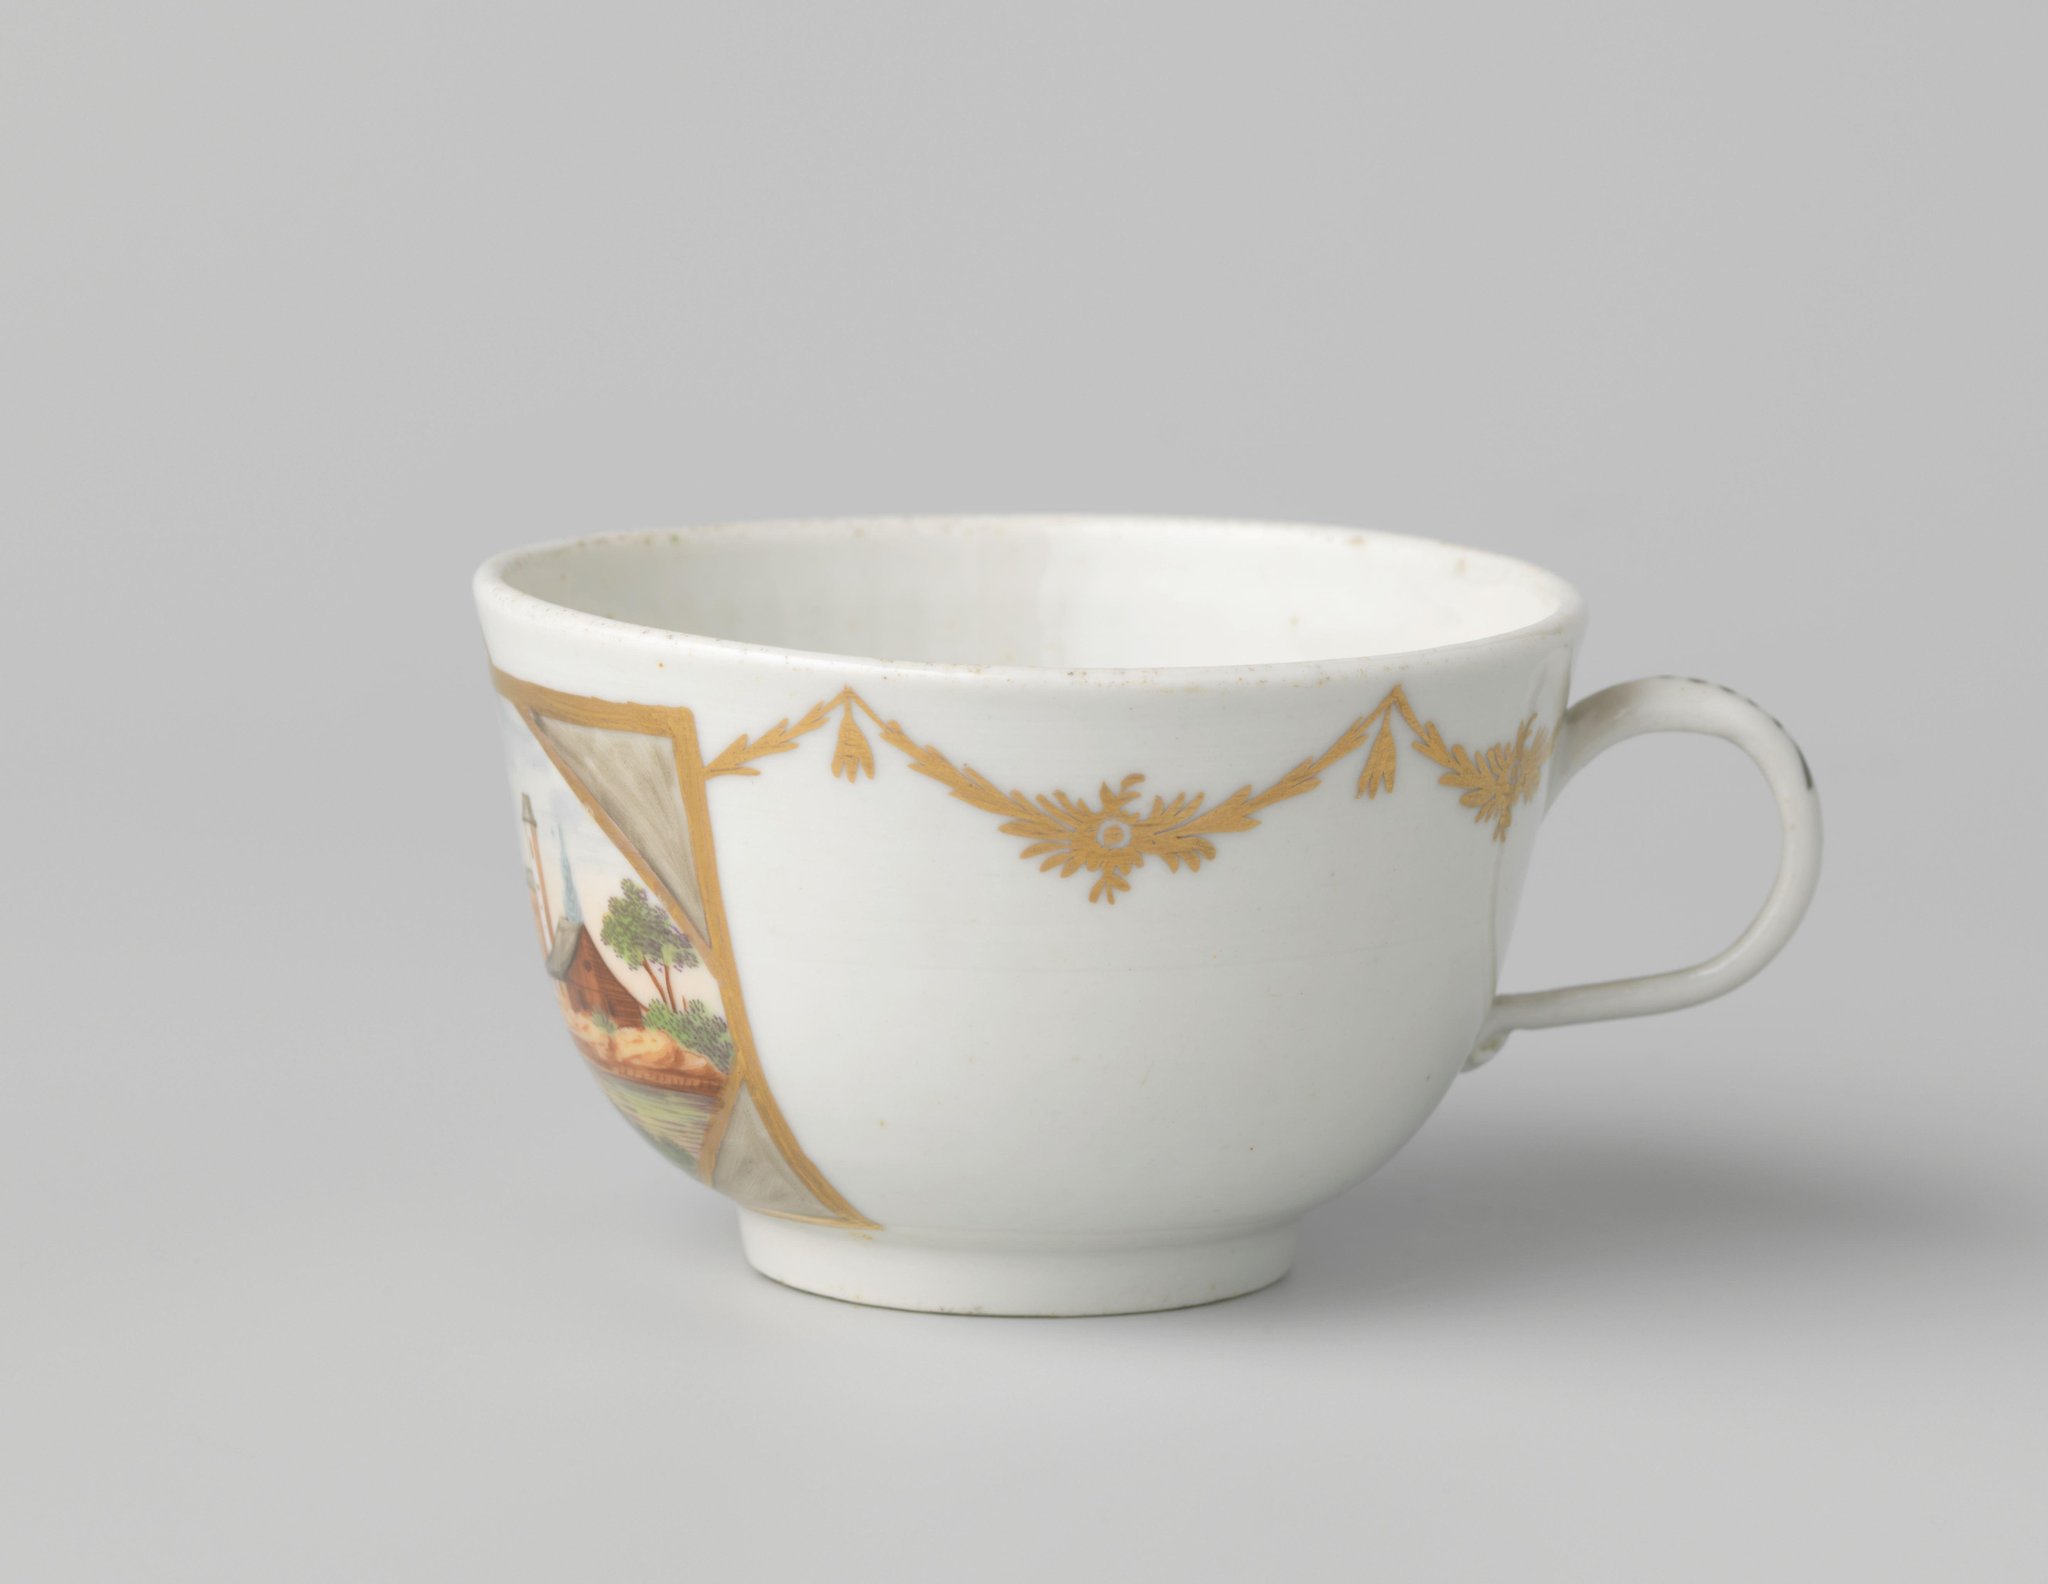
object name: cup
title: Cup with a water landscape and garlands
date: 1780-1800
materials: glaze, gold, paint, porcelain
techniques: firing, forming, gilding, turning, vitrification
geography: wallendorf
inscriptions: mark: ‘W’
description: Kop van porselein met een licht geribde wand en C-vormig oor, beschilderd op het glazuur in emailkleuren en goud. Op de buitenwand een rechthoekig vak met in een ovaal medaillon een rivierlandschap met een persoon op de oever naast een grote vaas op een voetstuk. Op de achtergrond enkele gebouwen. De buitenrand met een band van guirlandes. Het oor met stippen en bladmitieven. Gemerkt op de onderzijde met de W.